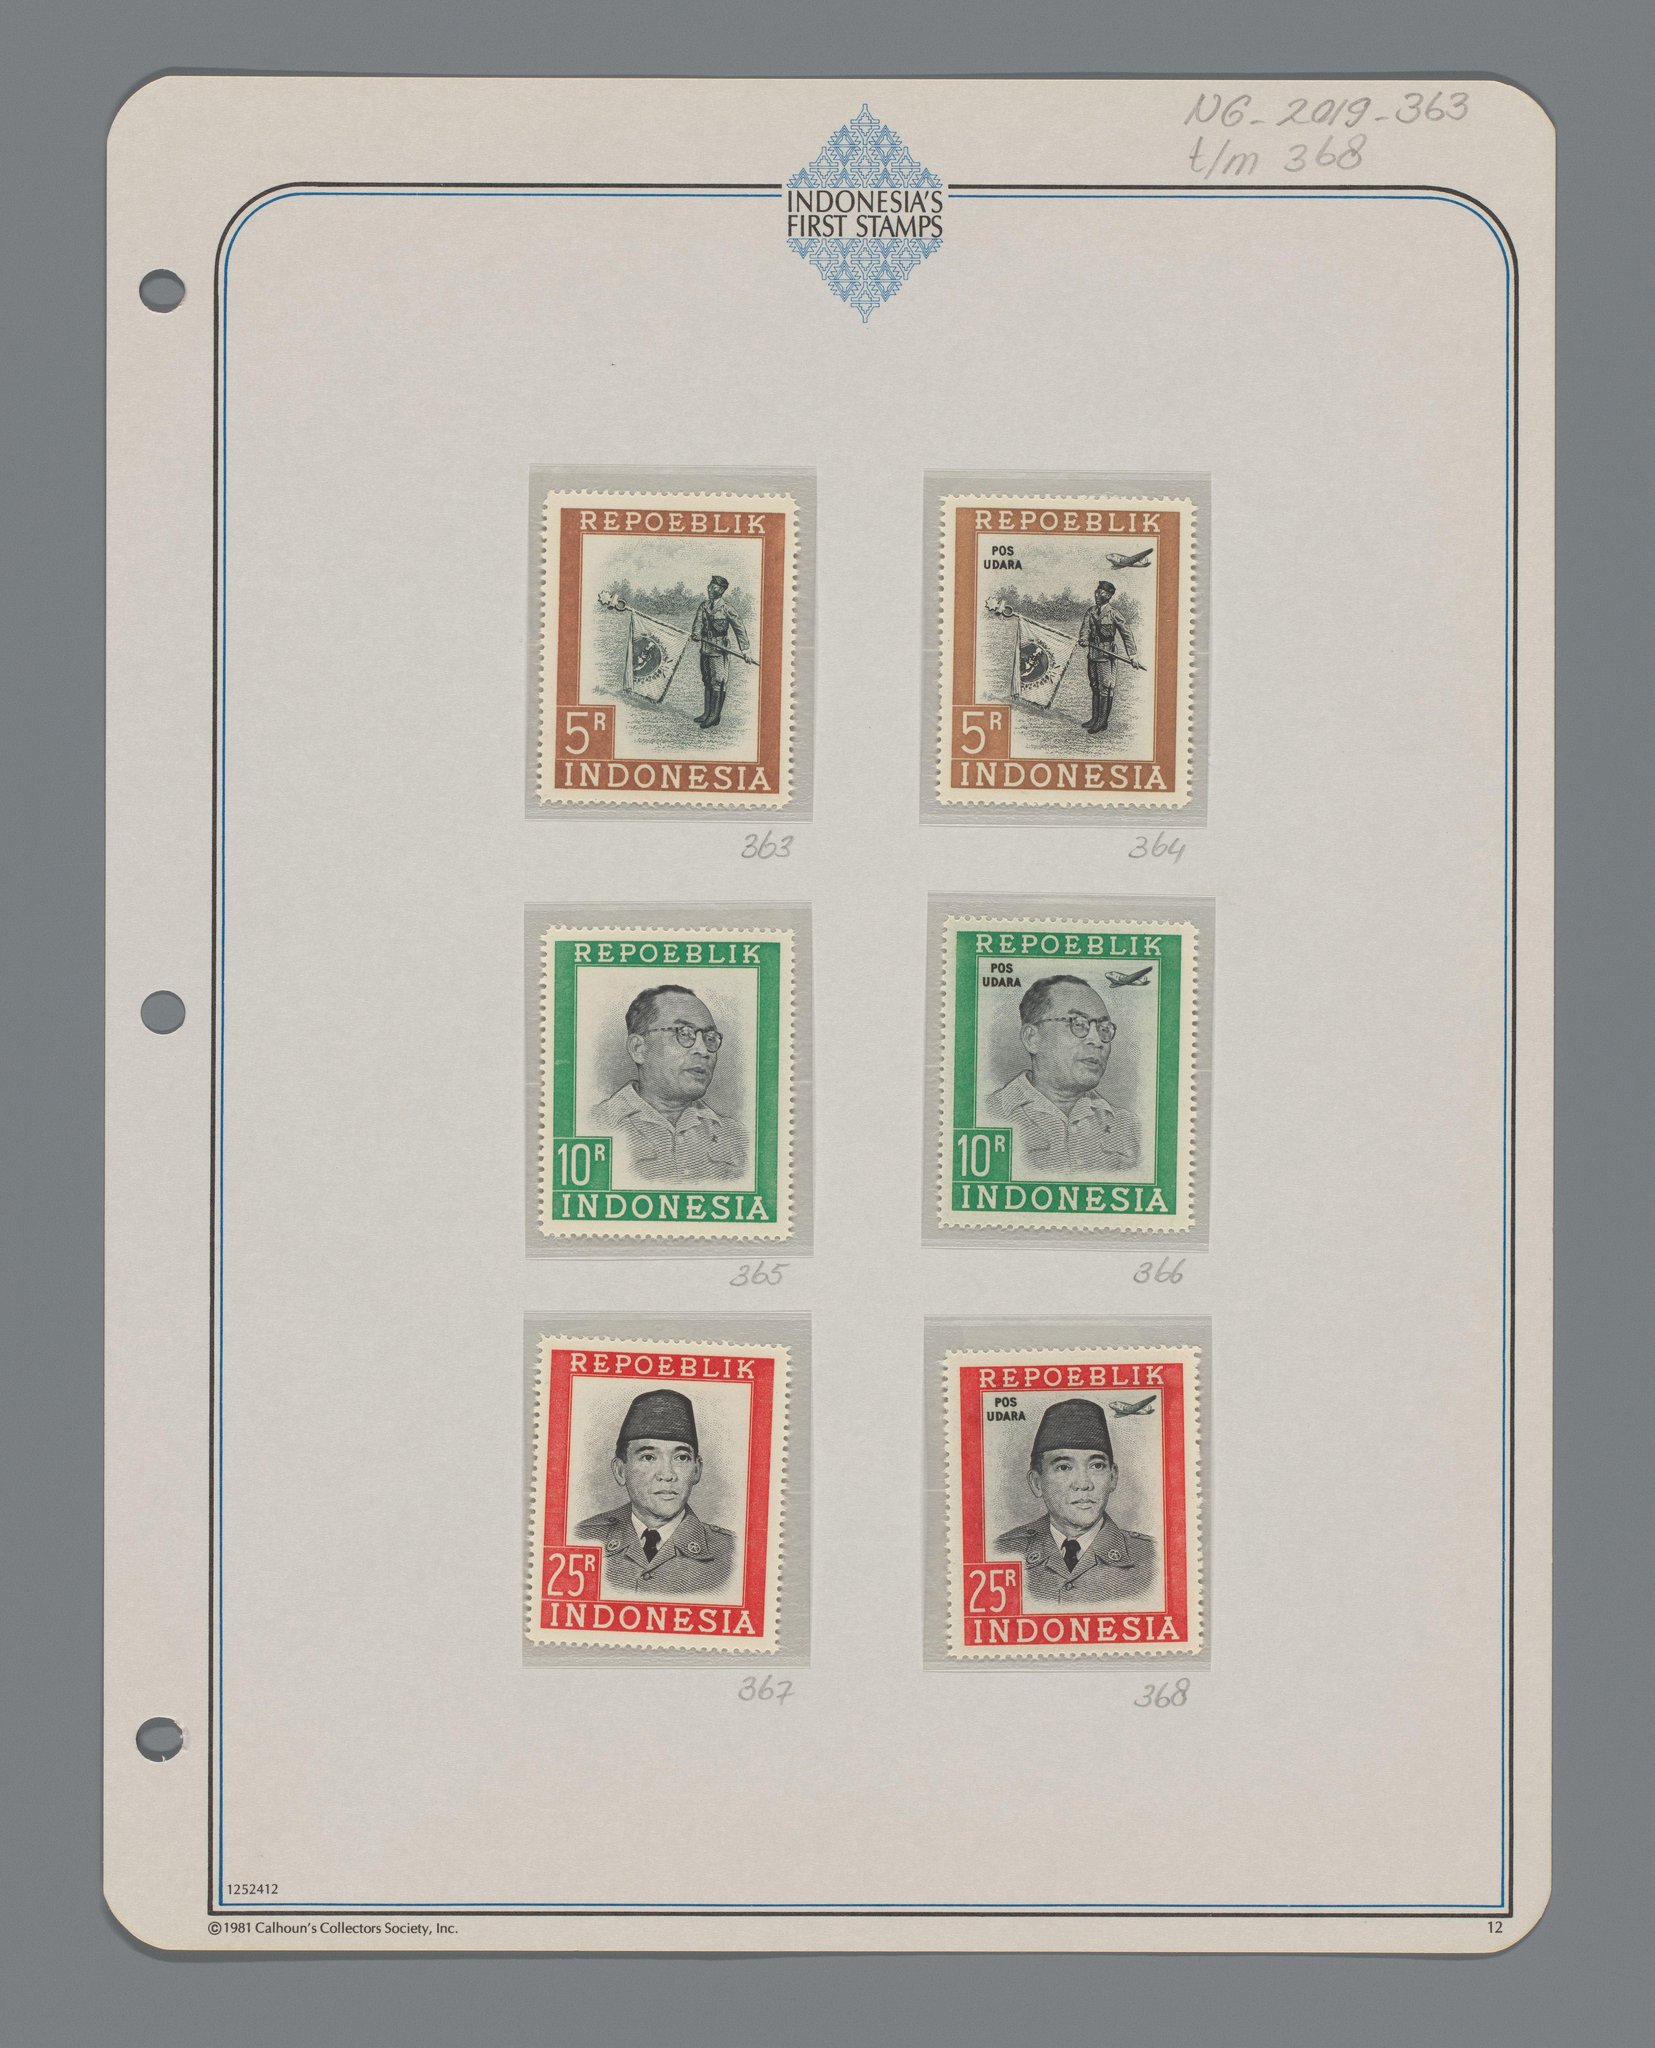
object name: postage stamp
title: Postzegel Republik Indonesia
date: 1949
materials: paper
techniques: photoaquatint, engraving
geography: philadelphia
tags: indonesia